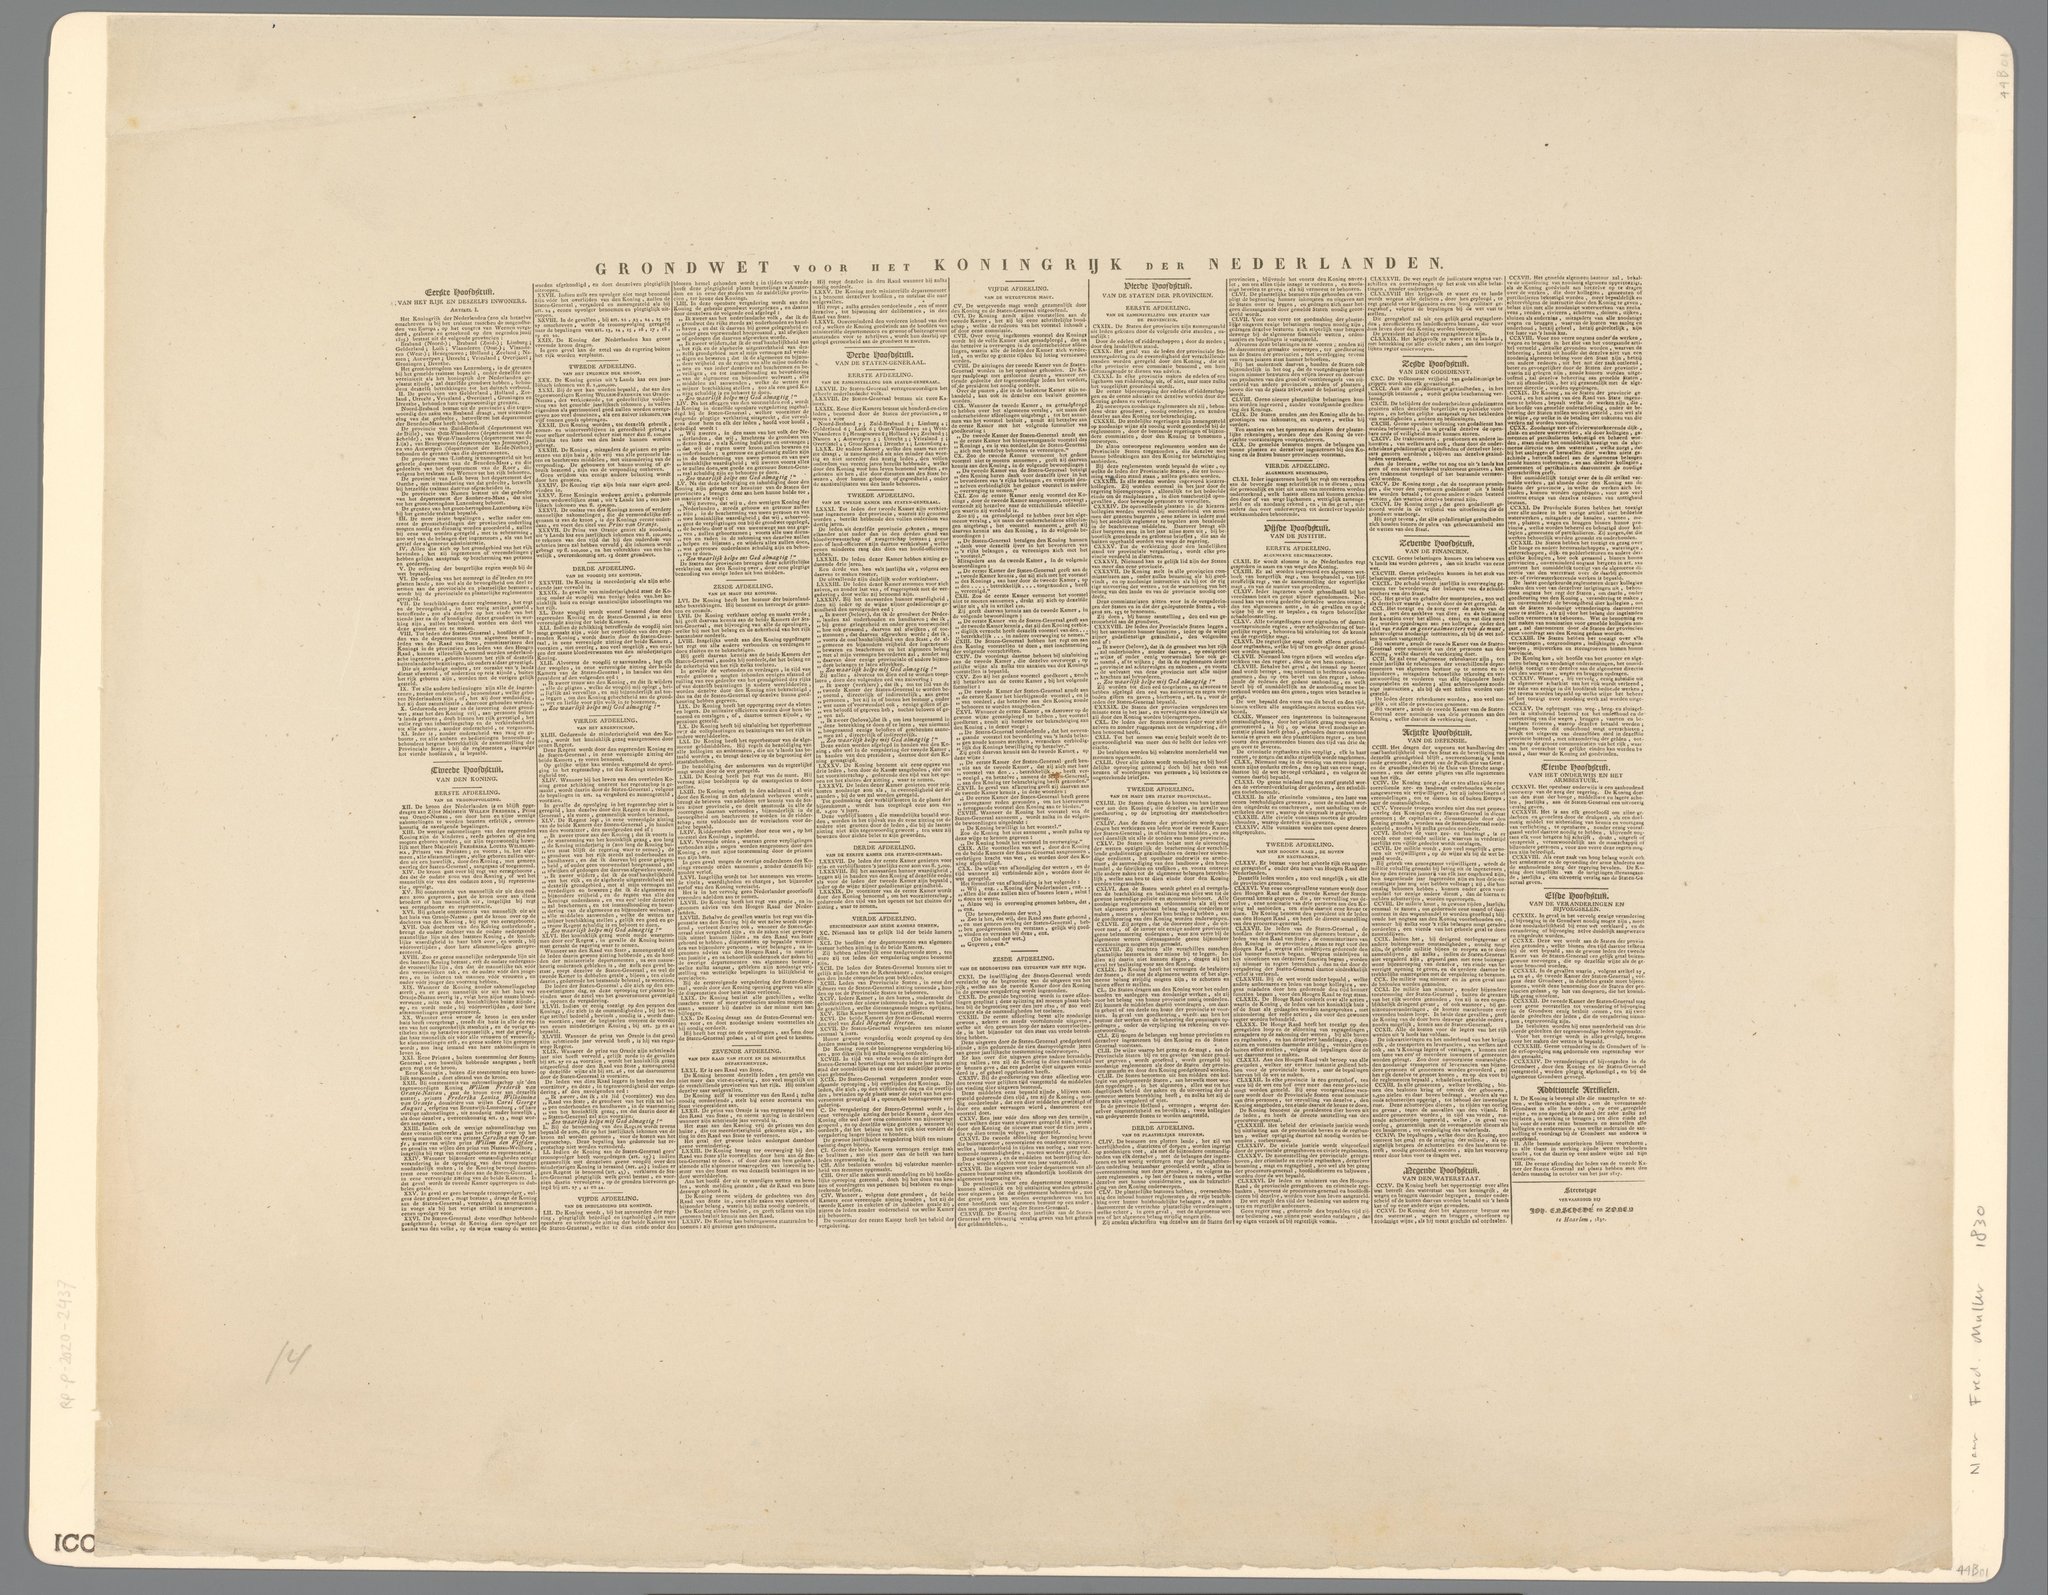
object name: text sheet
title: Grondwet voor het Koninkrijk der Nederlanden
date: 1830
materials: paper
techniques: printing block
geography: haarlem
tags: law and jurisprudence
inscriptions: collector's mark: Lugt 2228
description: Het gaat hier om de grondwet opgesteld in 1815, na vereniging van België en Nederland. De grondwet is nogmaals gedrukt in 1830, mogelijk naar aanleiding van het uitroepen van een zelfstandige staat door België.